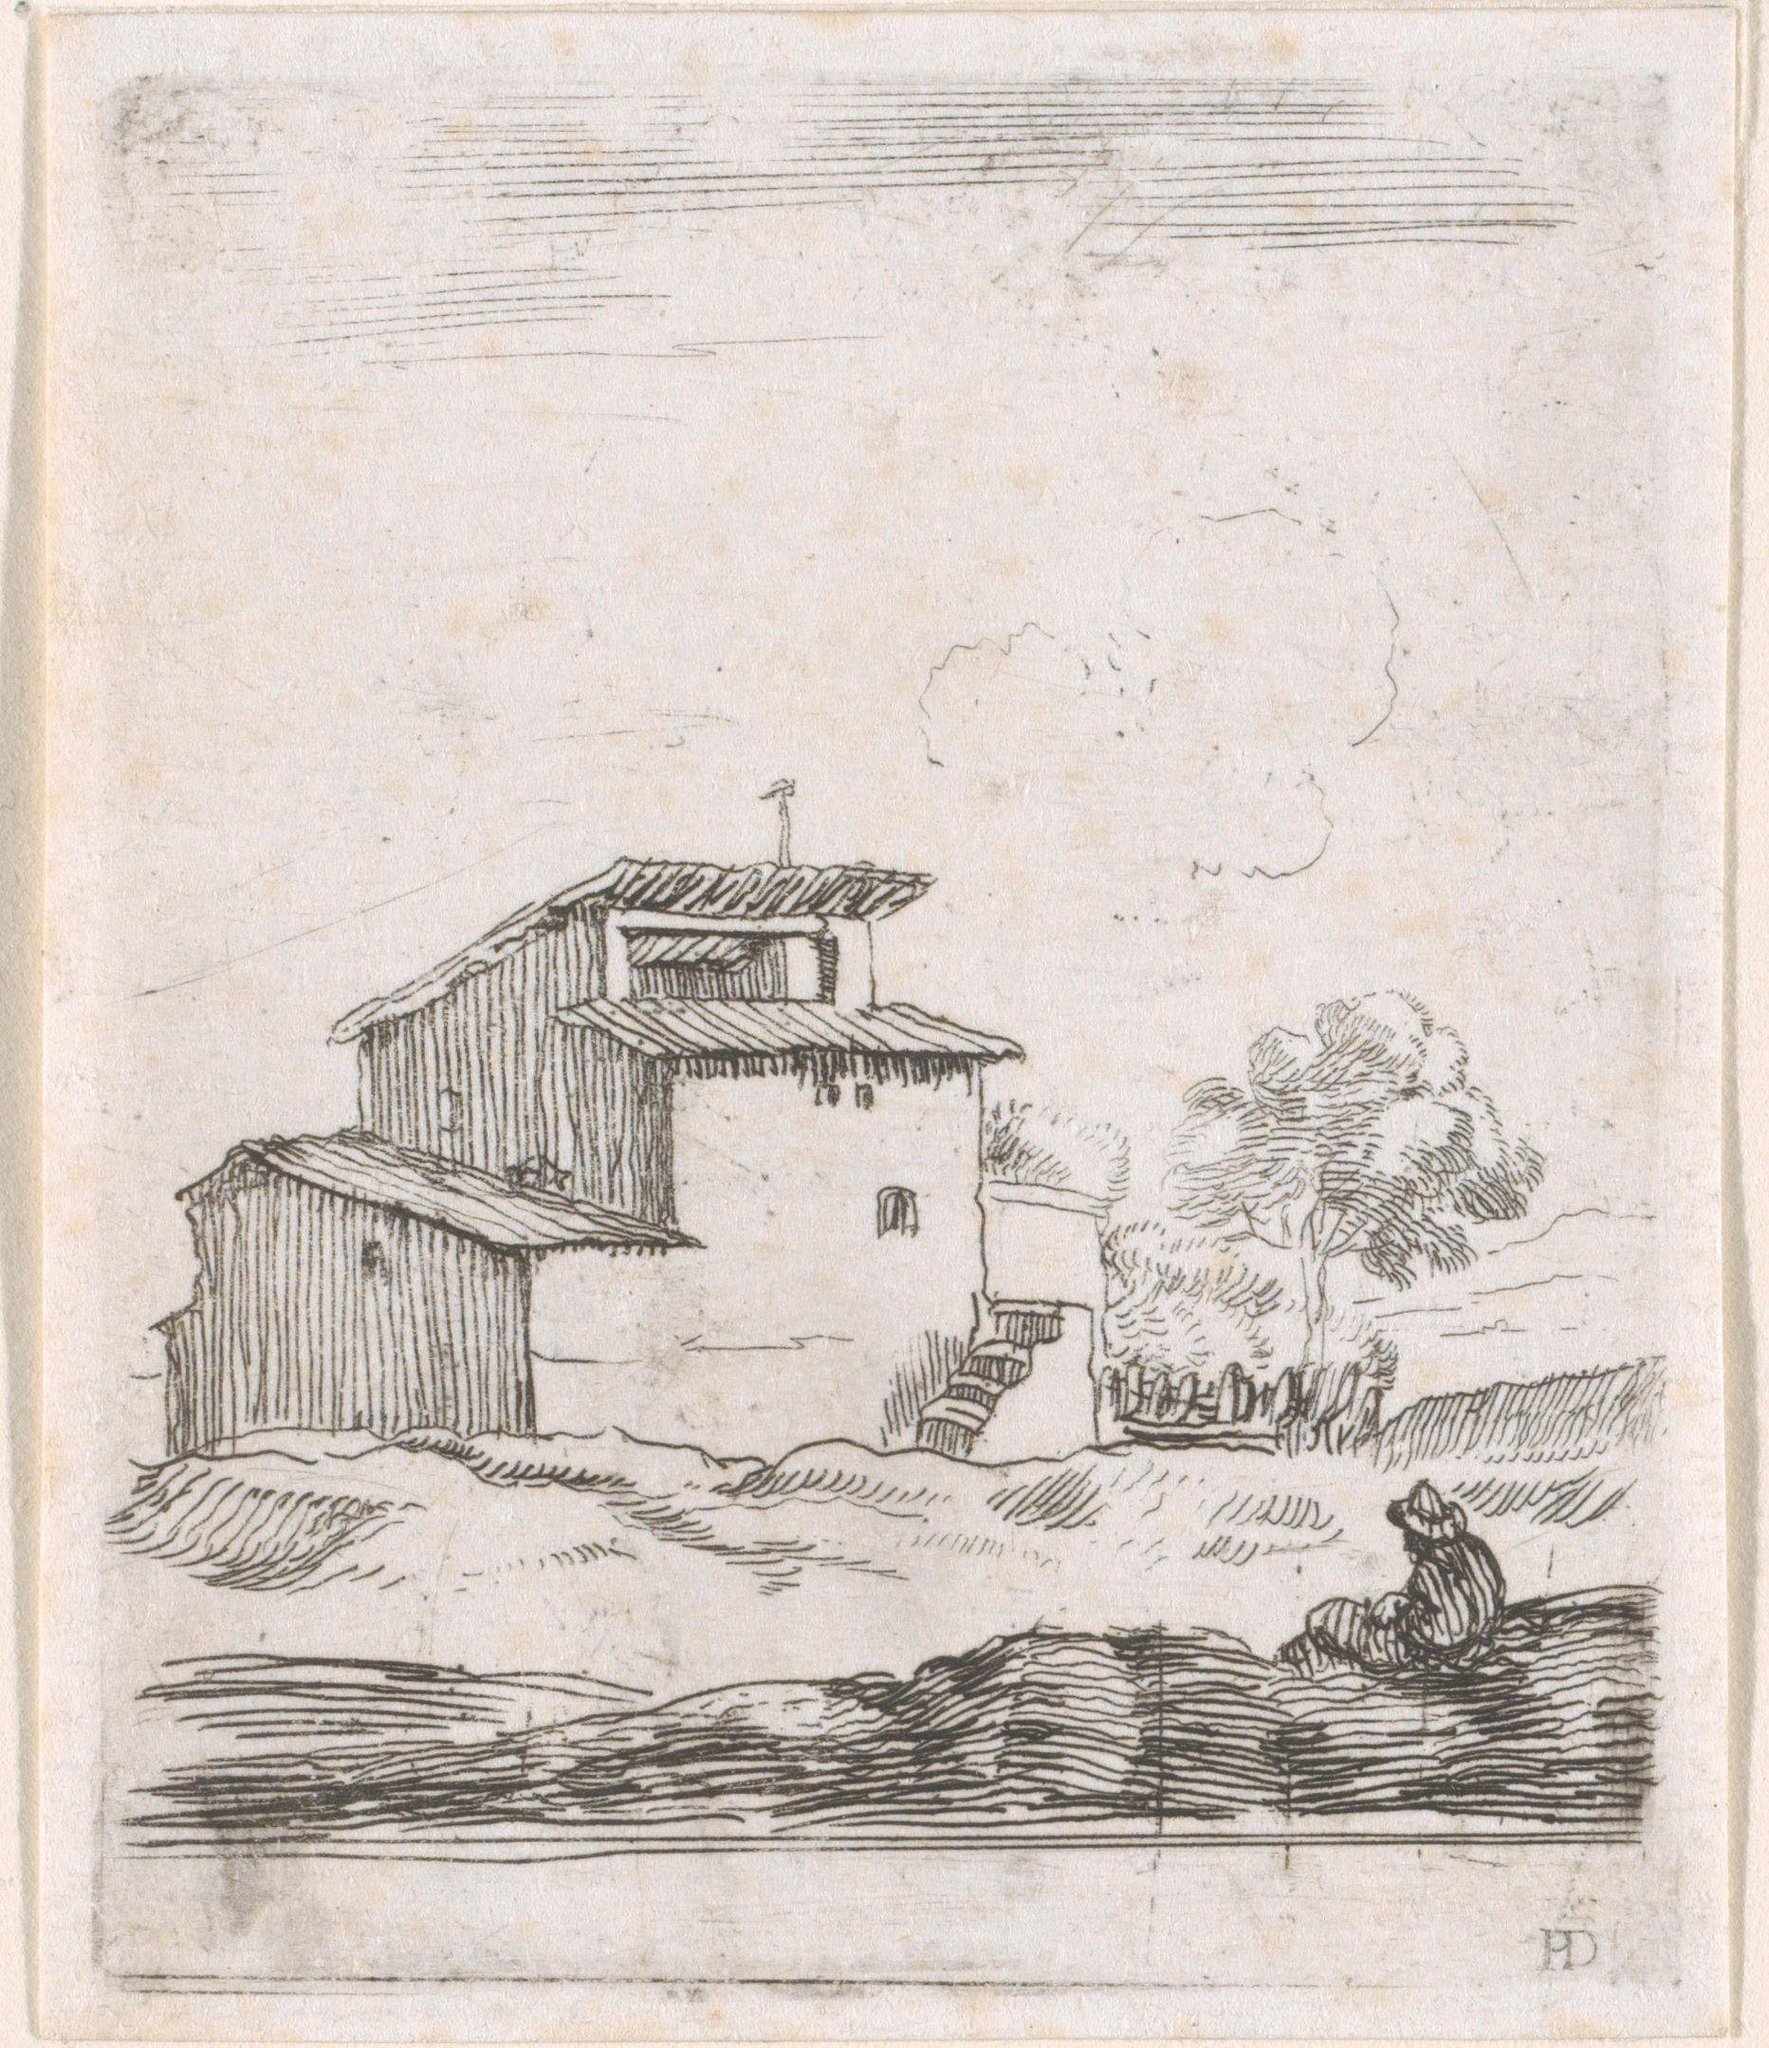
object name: print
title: Landschap met huis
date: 1620-1664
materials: paper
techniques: etching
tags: farm or solitary house in landscape - ii - ideal landscapes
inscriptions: collector's mark: Lugt 240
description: Gezicht op een huis in een landschap met op de voorgrond een zittende man, op de rug gezien.